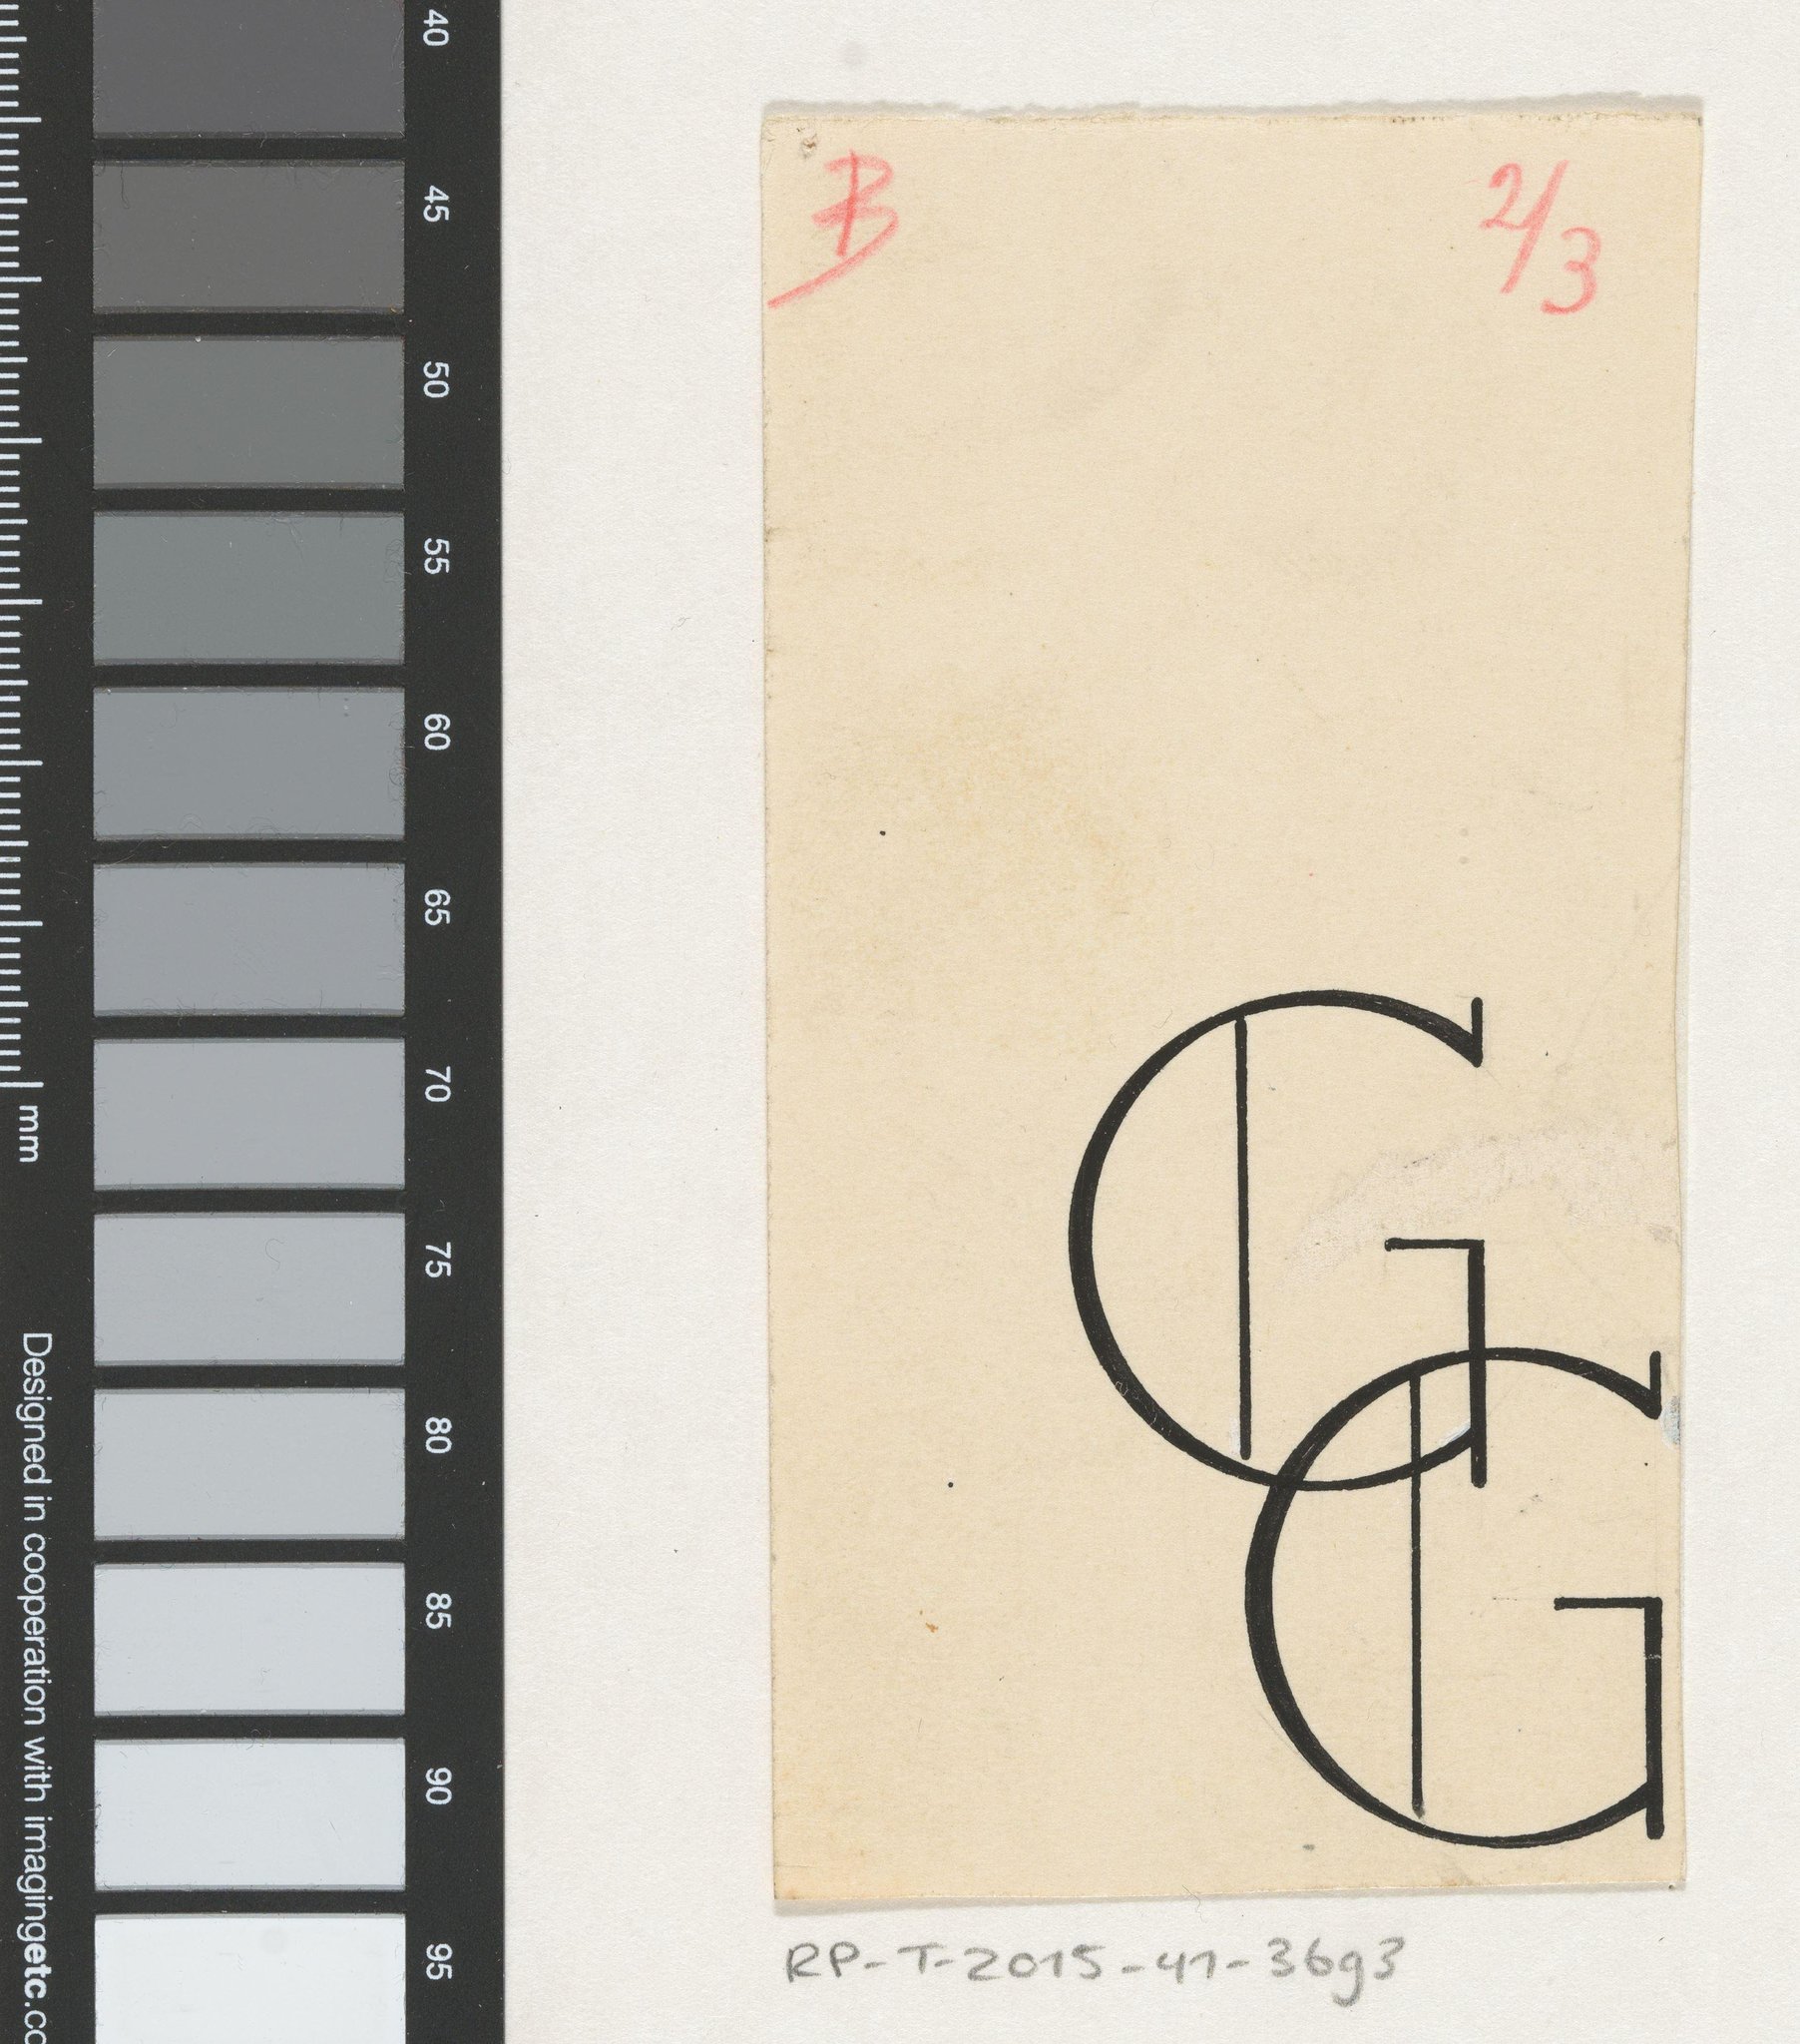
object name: boekillustratie ontwerp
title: Monogram GG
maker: Anonymous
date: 1900-1930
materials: paint, ink, paper, pencil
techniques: brush, pen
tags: magic mathematical figures; magic numbers, words, monograms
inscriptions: collector's mark: Lugt 2228a, :, annotation: ‘B’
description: Twee deels vervlochten hoofdletters 'G'.